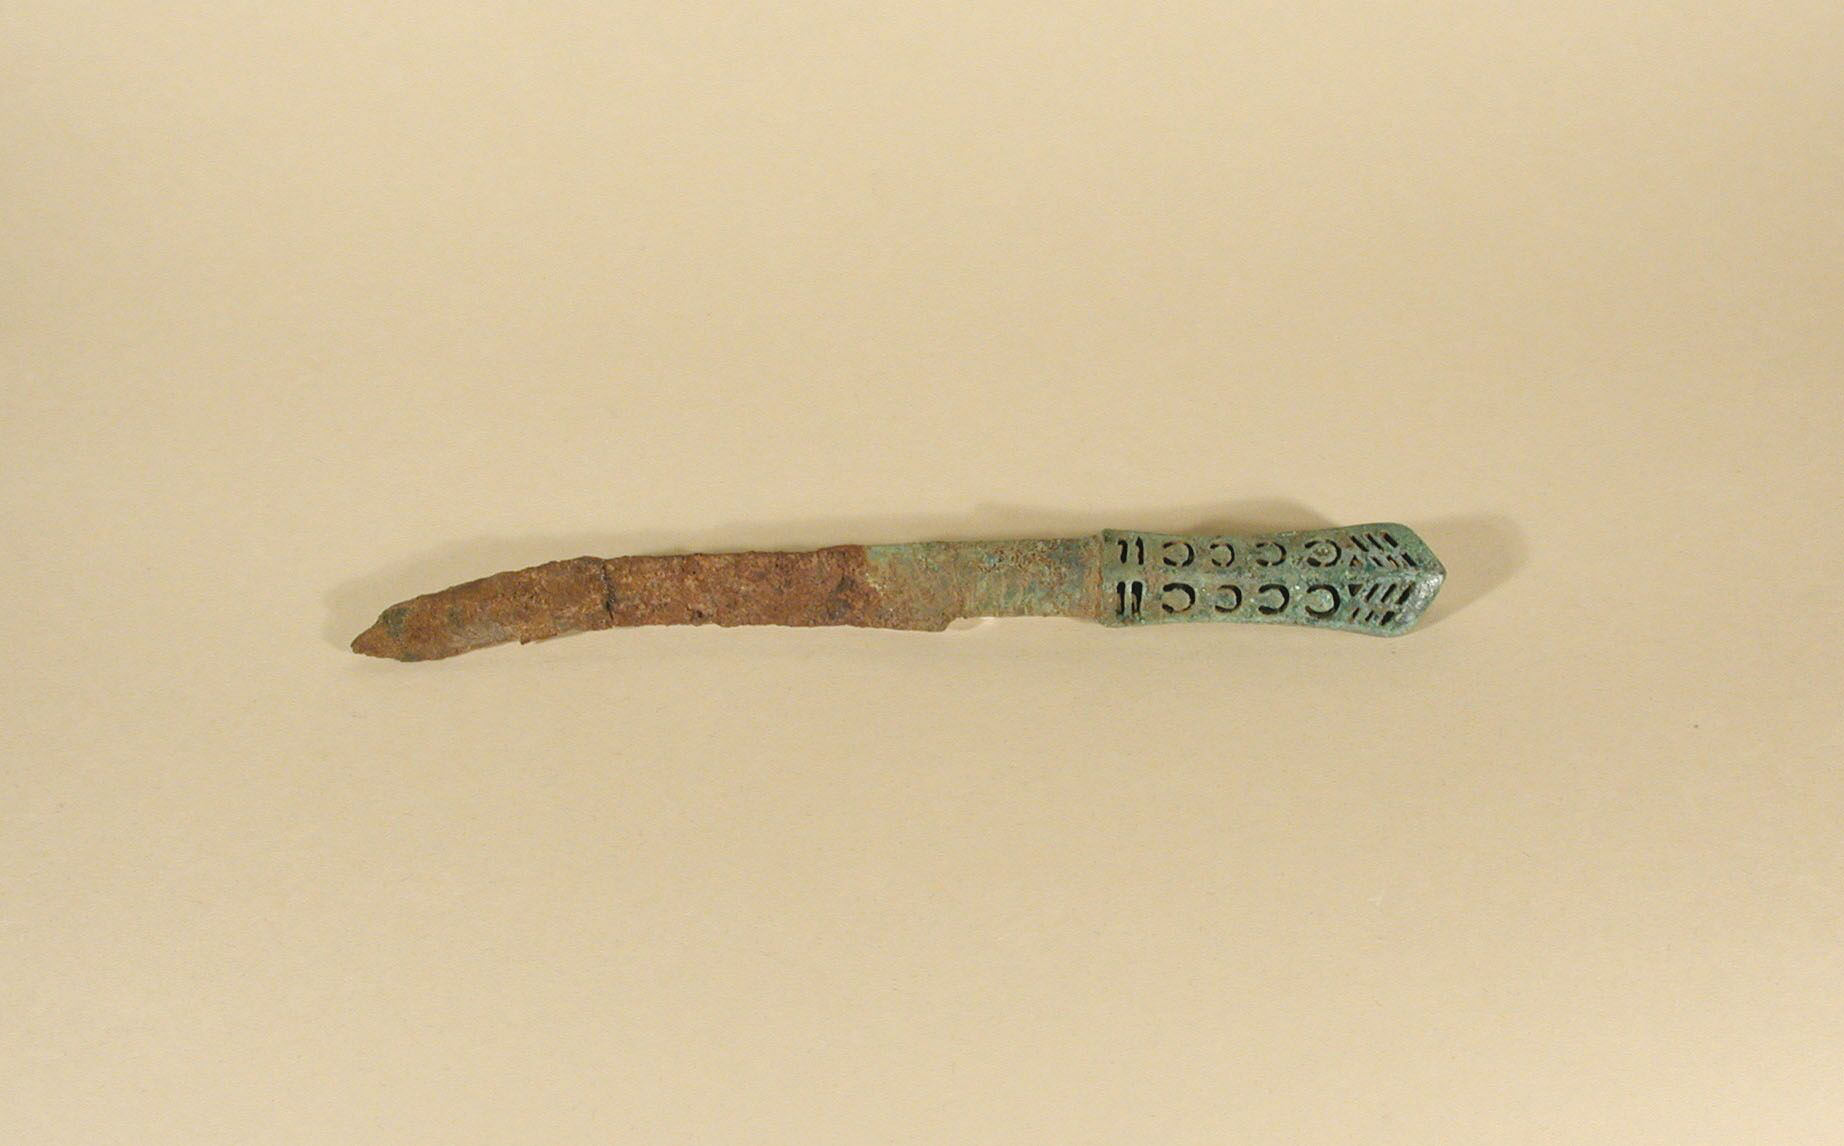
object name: knife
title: Knife with Iron Blade and Hollow Handle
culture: chinese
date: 1000-1 BCE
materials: bronze, iron